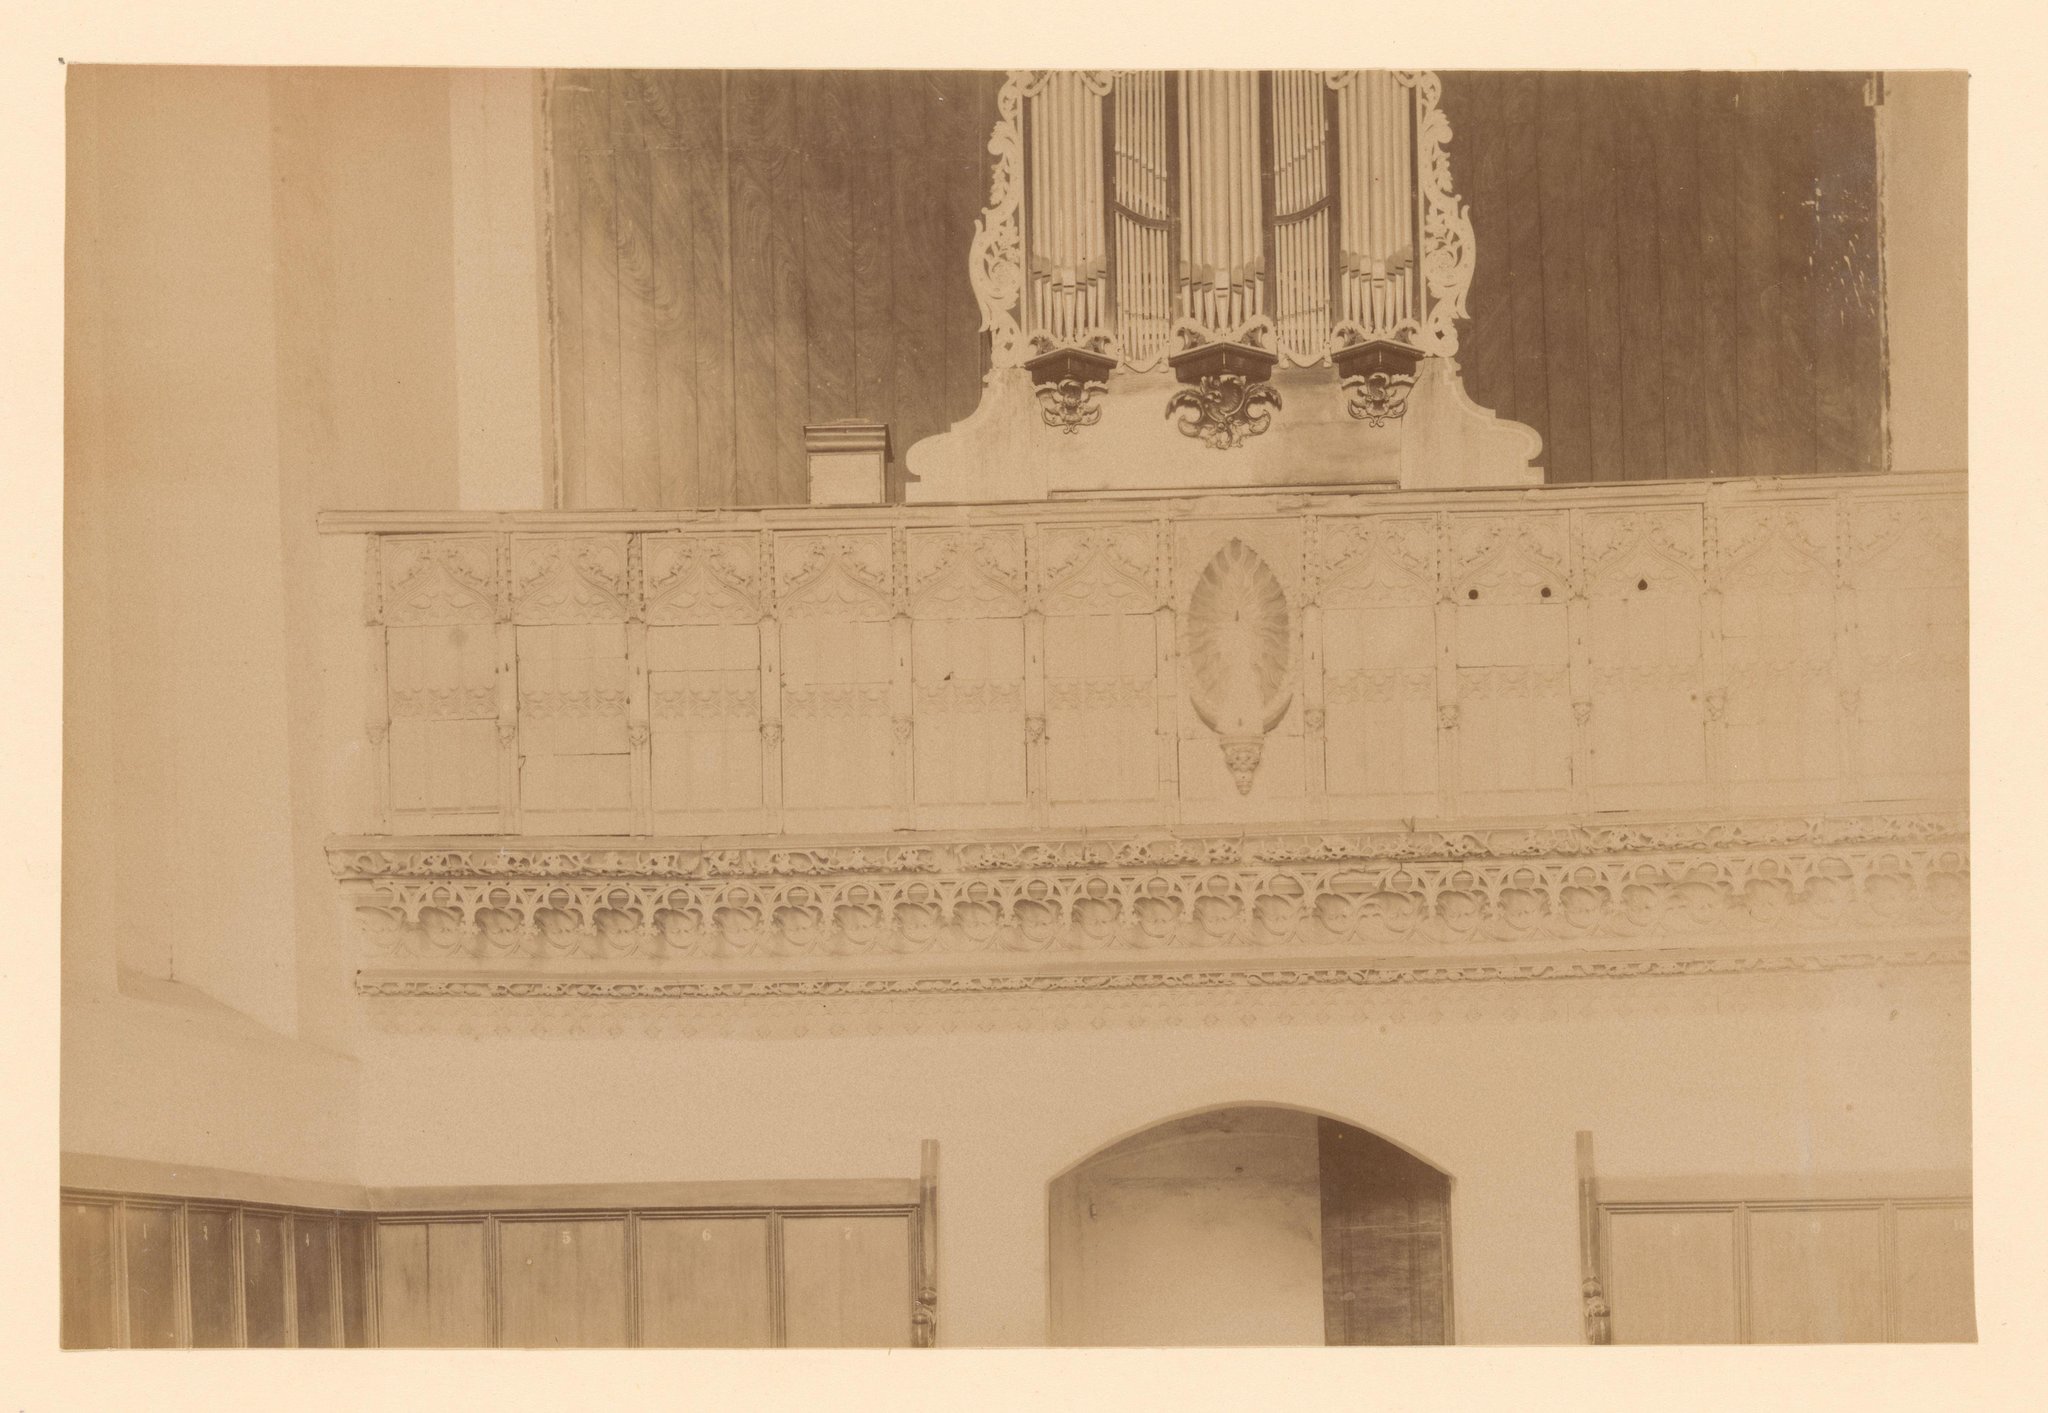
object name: photograph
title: Doksaal in de Kloosterkerk Ter Apel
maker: anoniem (monumentenzorg)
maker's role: fotograaf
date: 1893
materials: cardboard, photographic support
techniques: albumen print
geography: ter apel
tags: rood-screen, choir-screen; iconostasis, interior of church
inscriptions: annotation: ‘Ter Apel/ Jube in de kerk/ totaal aanzicht/ sept 1893’, annotation: ‘Ter Apel’